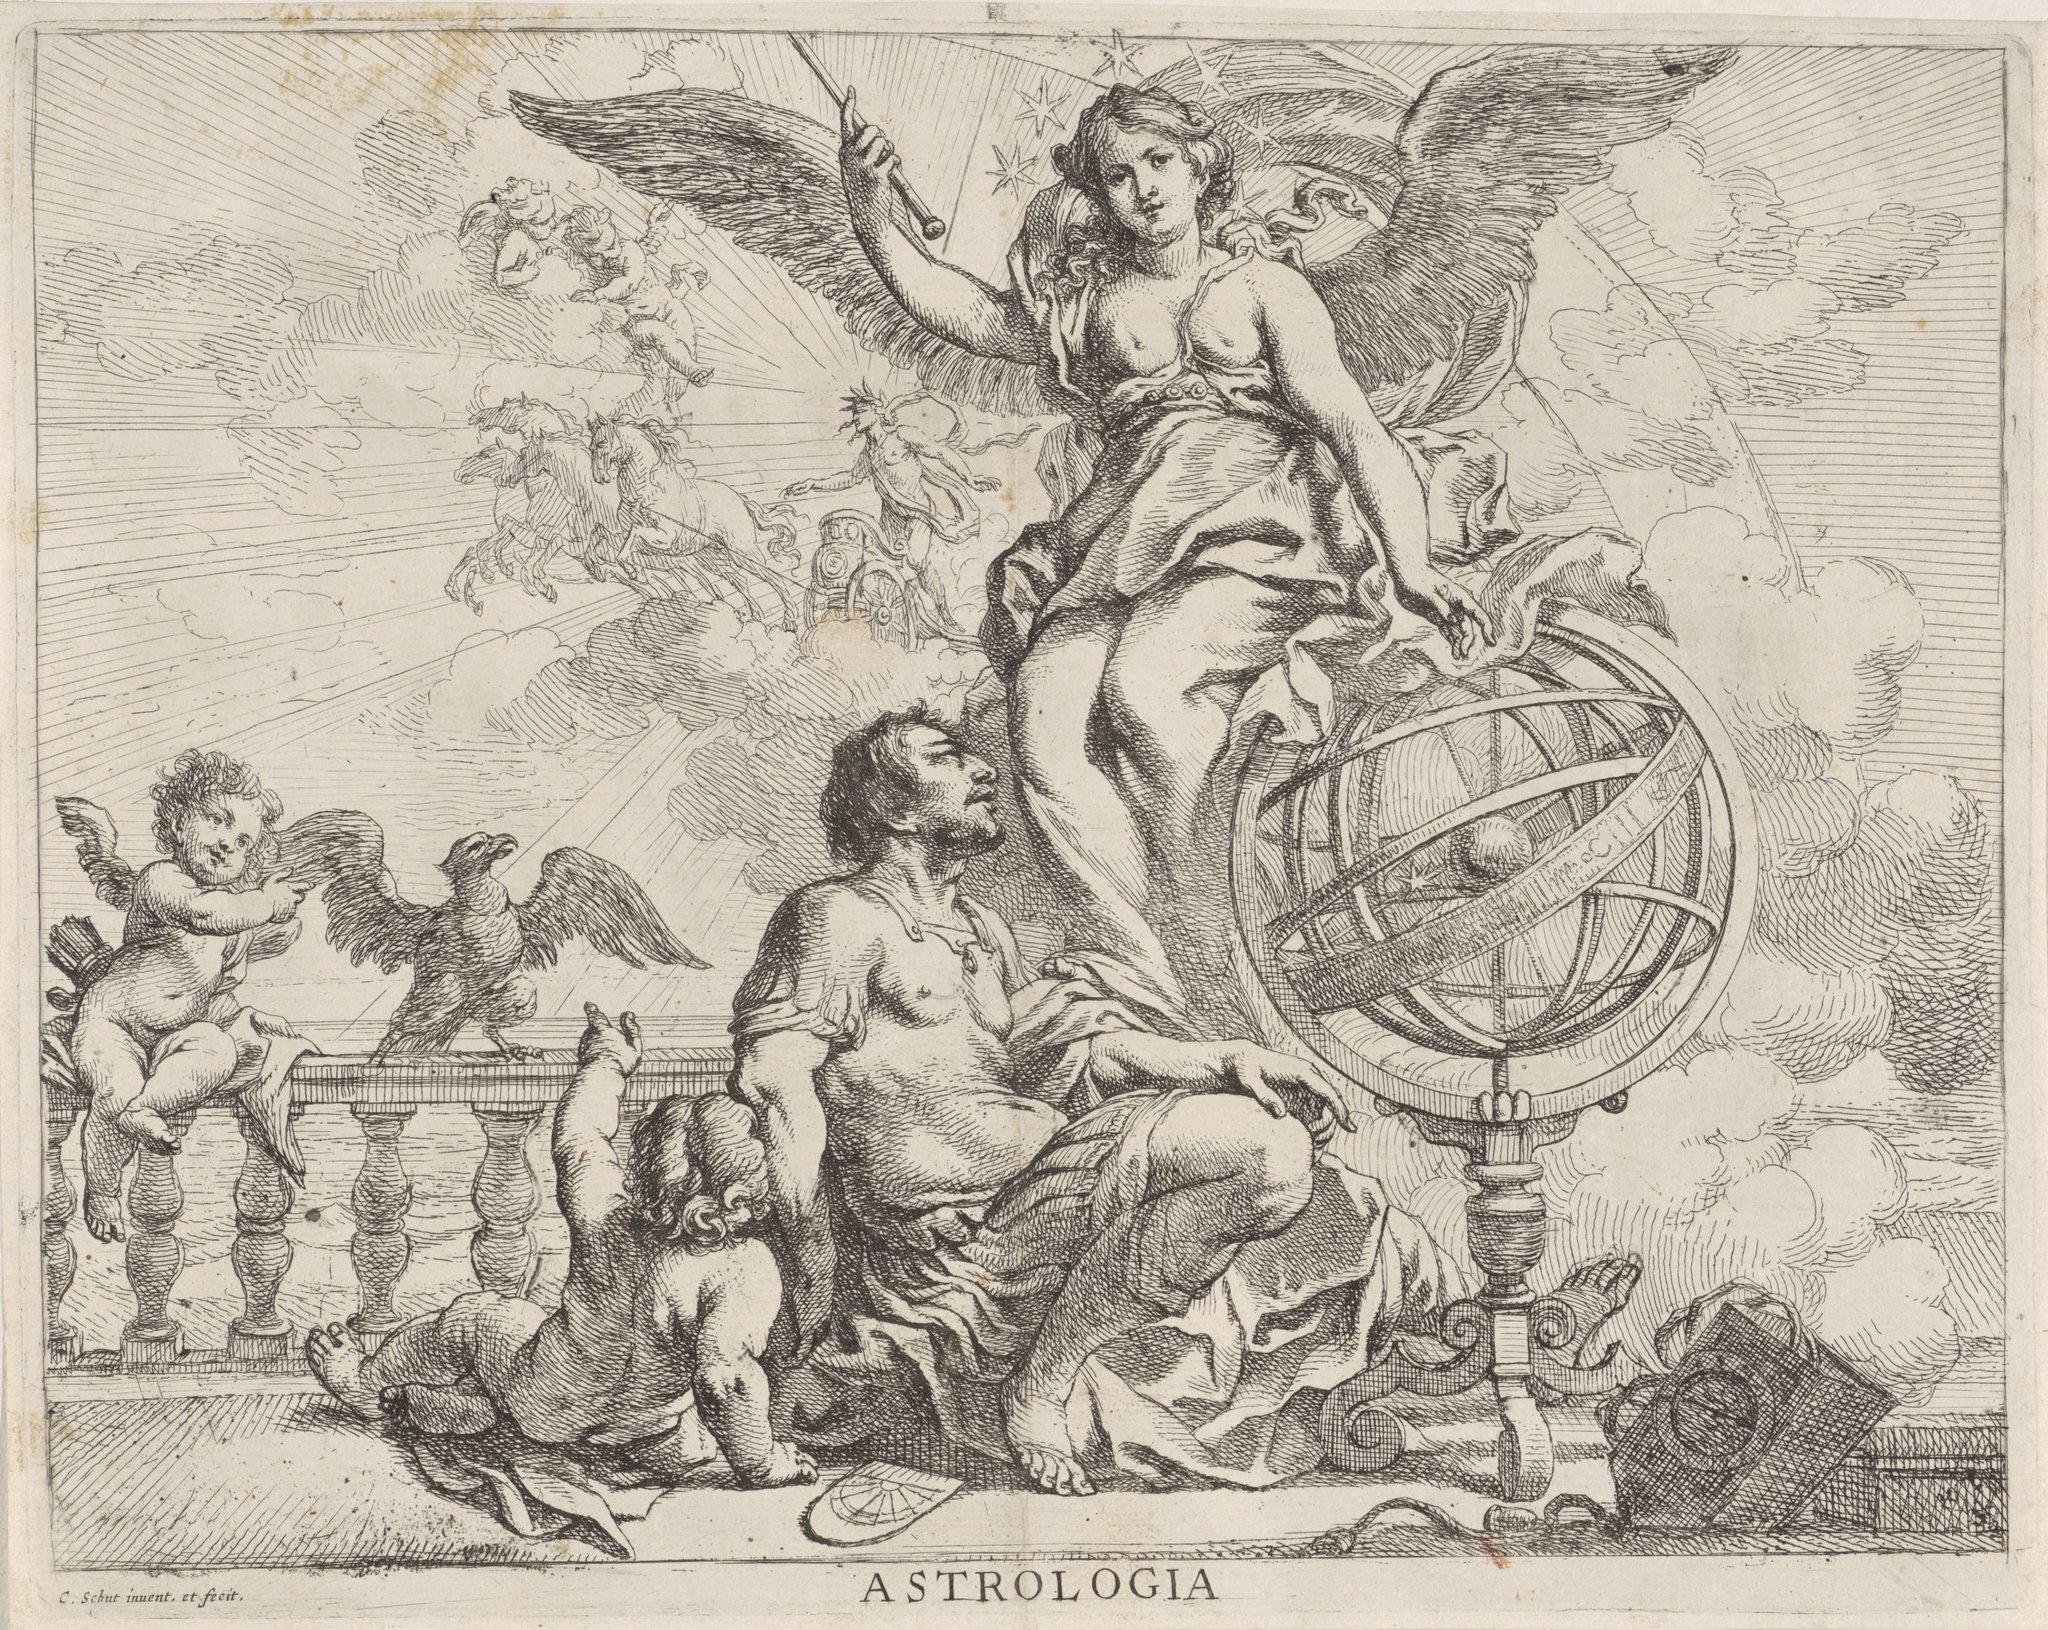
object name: print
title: Astrologia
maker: cornelis schut (i)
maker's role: draughtsman, print maker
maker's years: 1597-1655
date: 1618-1655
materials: paper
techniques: engraving, etching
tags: apollo as sun-god, i.e. sol (helius), titan, 'astrologia' (ripa), armillary sphere, skeleton celestial globe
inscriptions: collector's mark: Lugt 240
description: Een man kijkt op naar een gevleugelde Astrologia, die haar hand bij een armillarium houdt. Een adelaar en een putto zitten op een balustrade met zicht op zee. Een andere putto wijst ophoog naar Apollo in zijn hemelwagen.